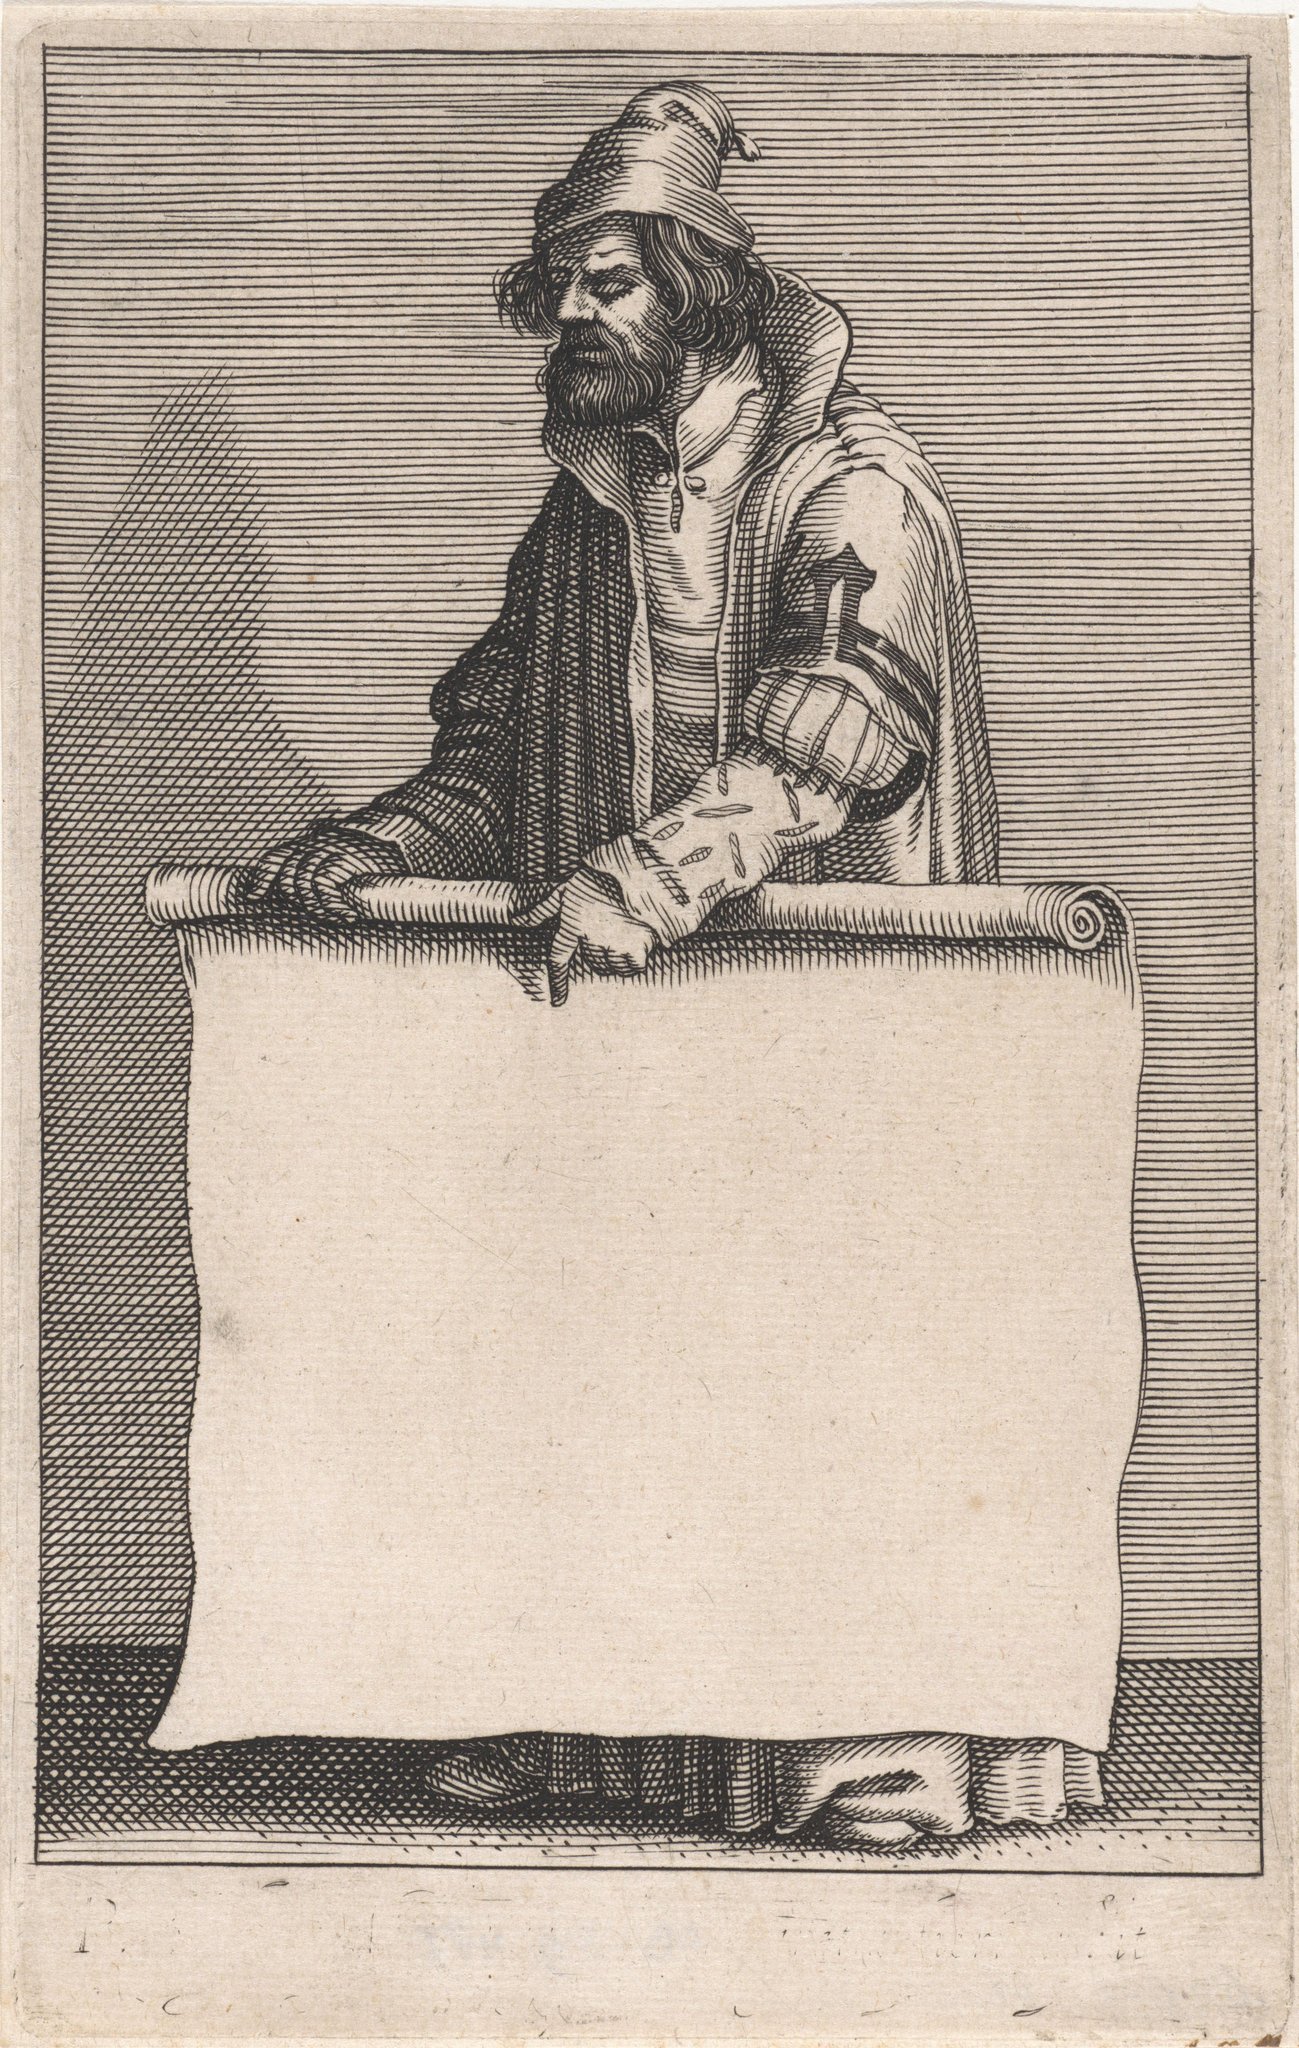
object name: print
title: Man met rol papier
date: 1601-1657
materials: paper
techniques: engraving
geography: amsterdam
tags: scroll - ll - scroll unfolded, adult man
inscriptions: collector's mark: Lugt 240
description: Man met een volle baard, die een uitgerolde boekrol in de hand houdt. Hij wijst met zijn vinger op het onbeschreven schrijfvlak.